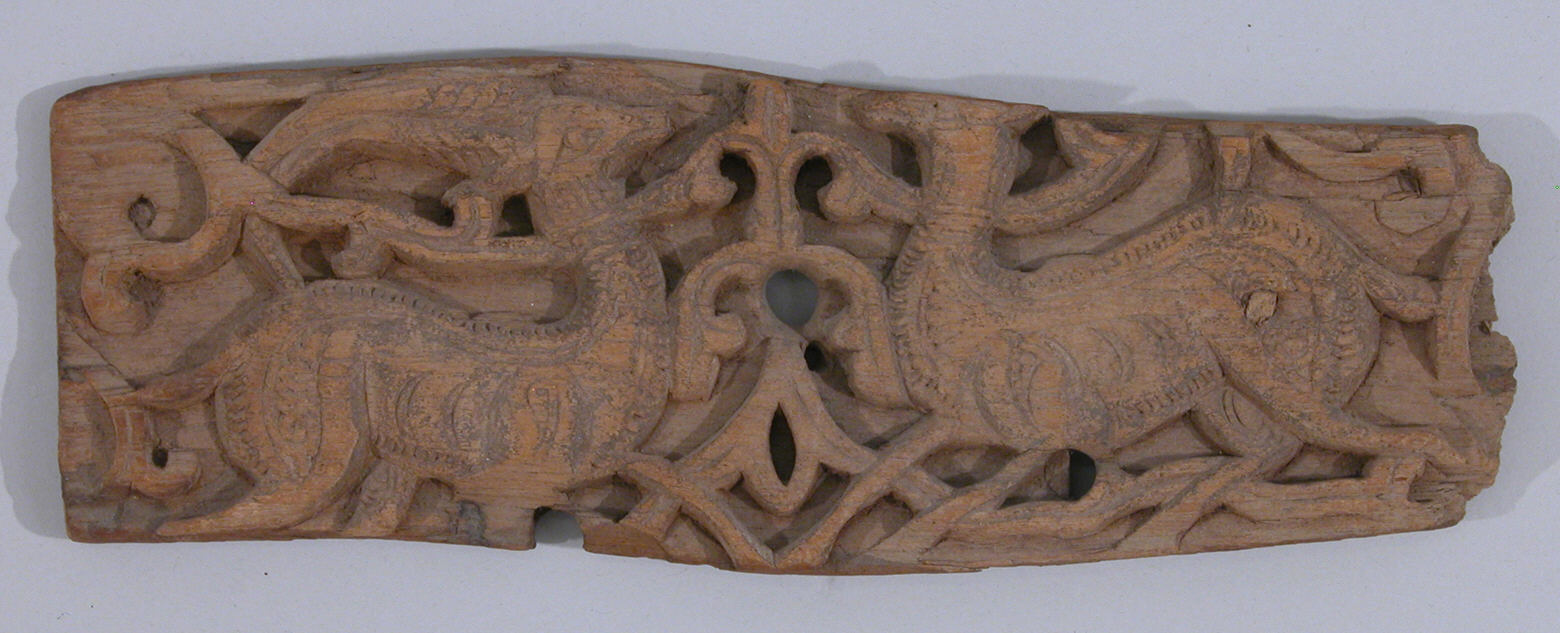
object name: panel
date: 1001-1100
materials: wood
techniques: carving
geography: egypt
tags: animals